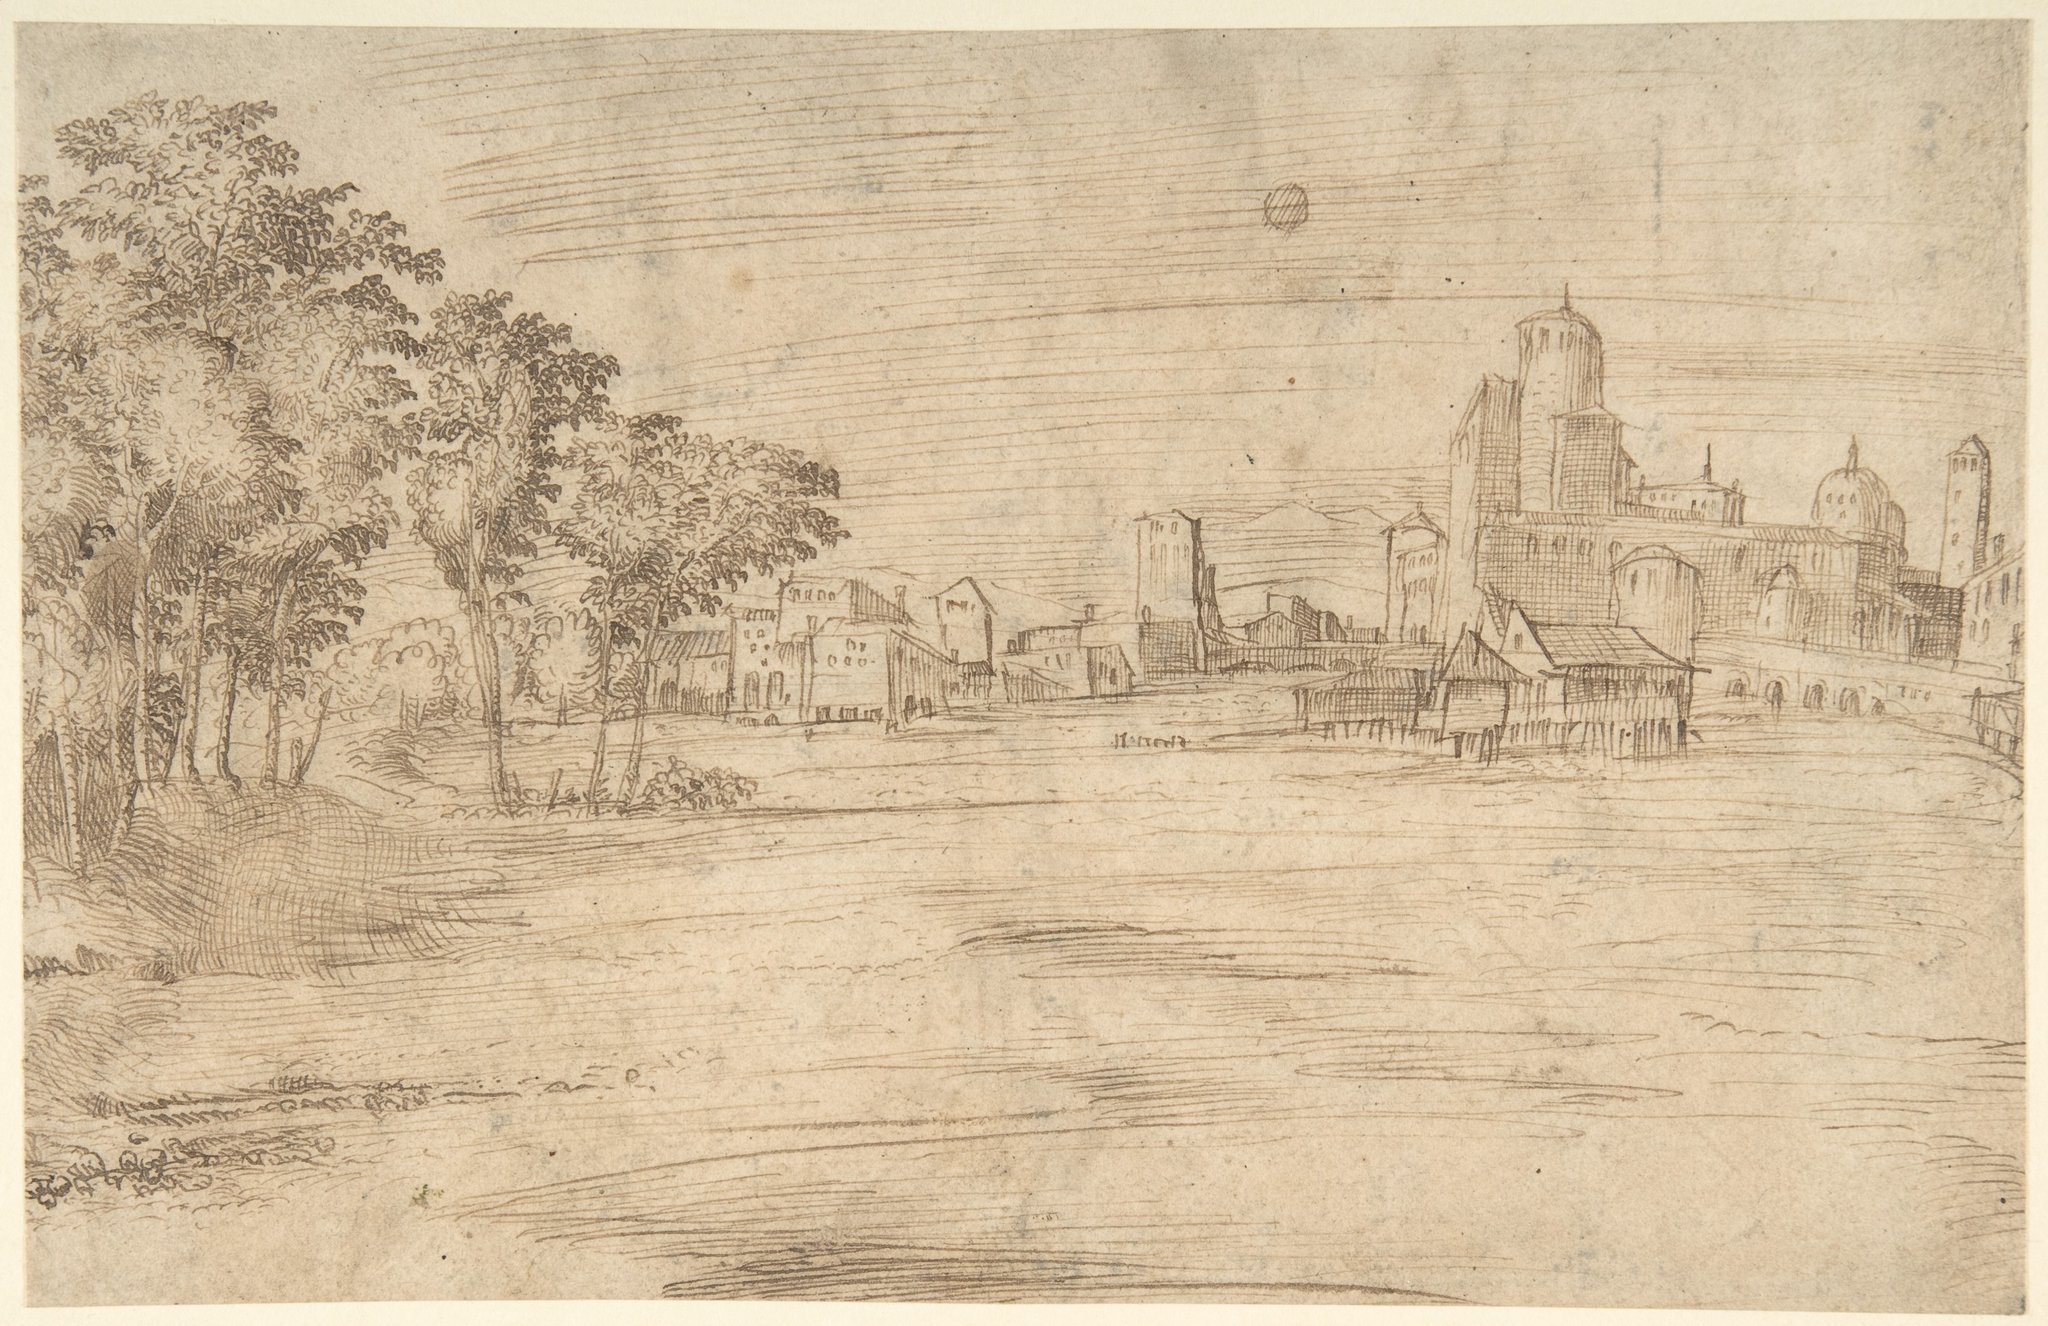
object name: drawing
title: Landscape with Buildings (recto); Studies for a Flagellation (verso)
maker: anonymous, italian, 16th century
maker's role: artist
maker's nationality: italian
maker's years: 1550-1600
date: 1501-1600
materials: ink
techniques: pen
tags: buildings,landscapes,trees